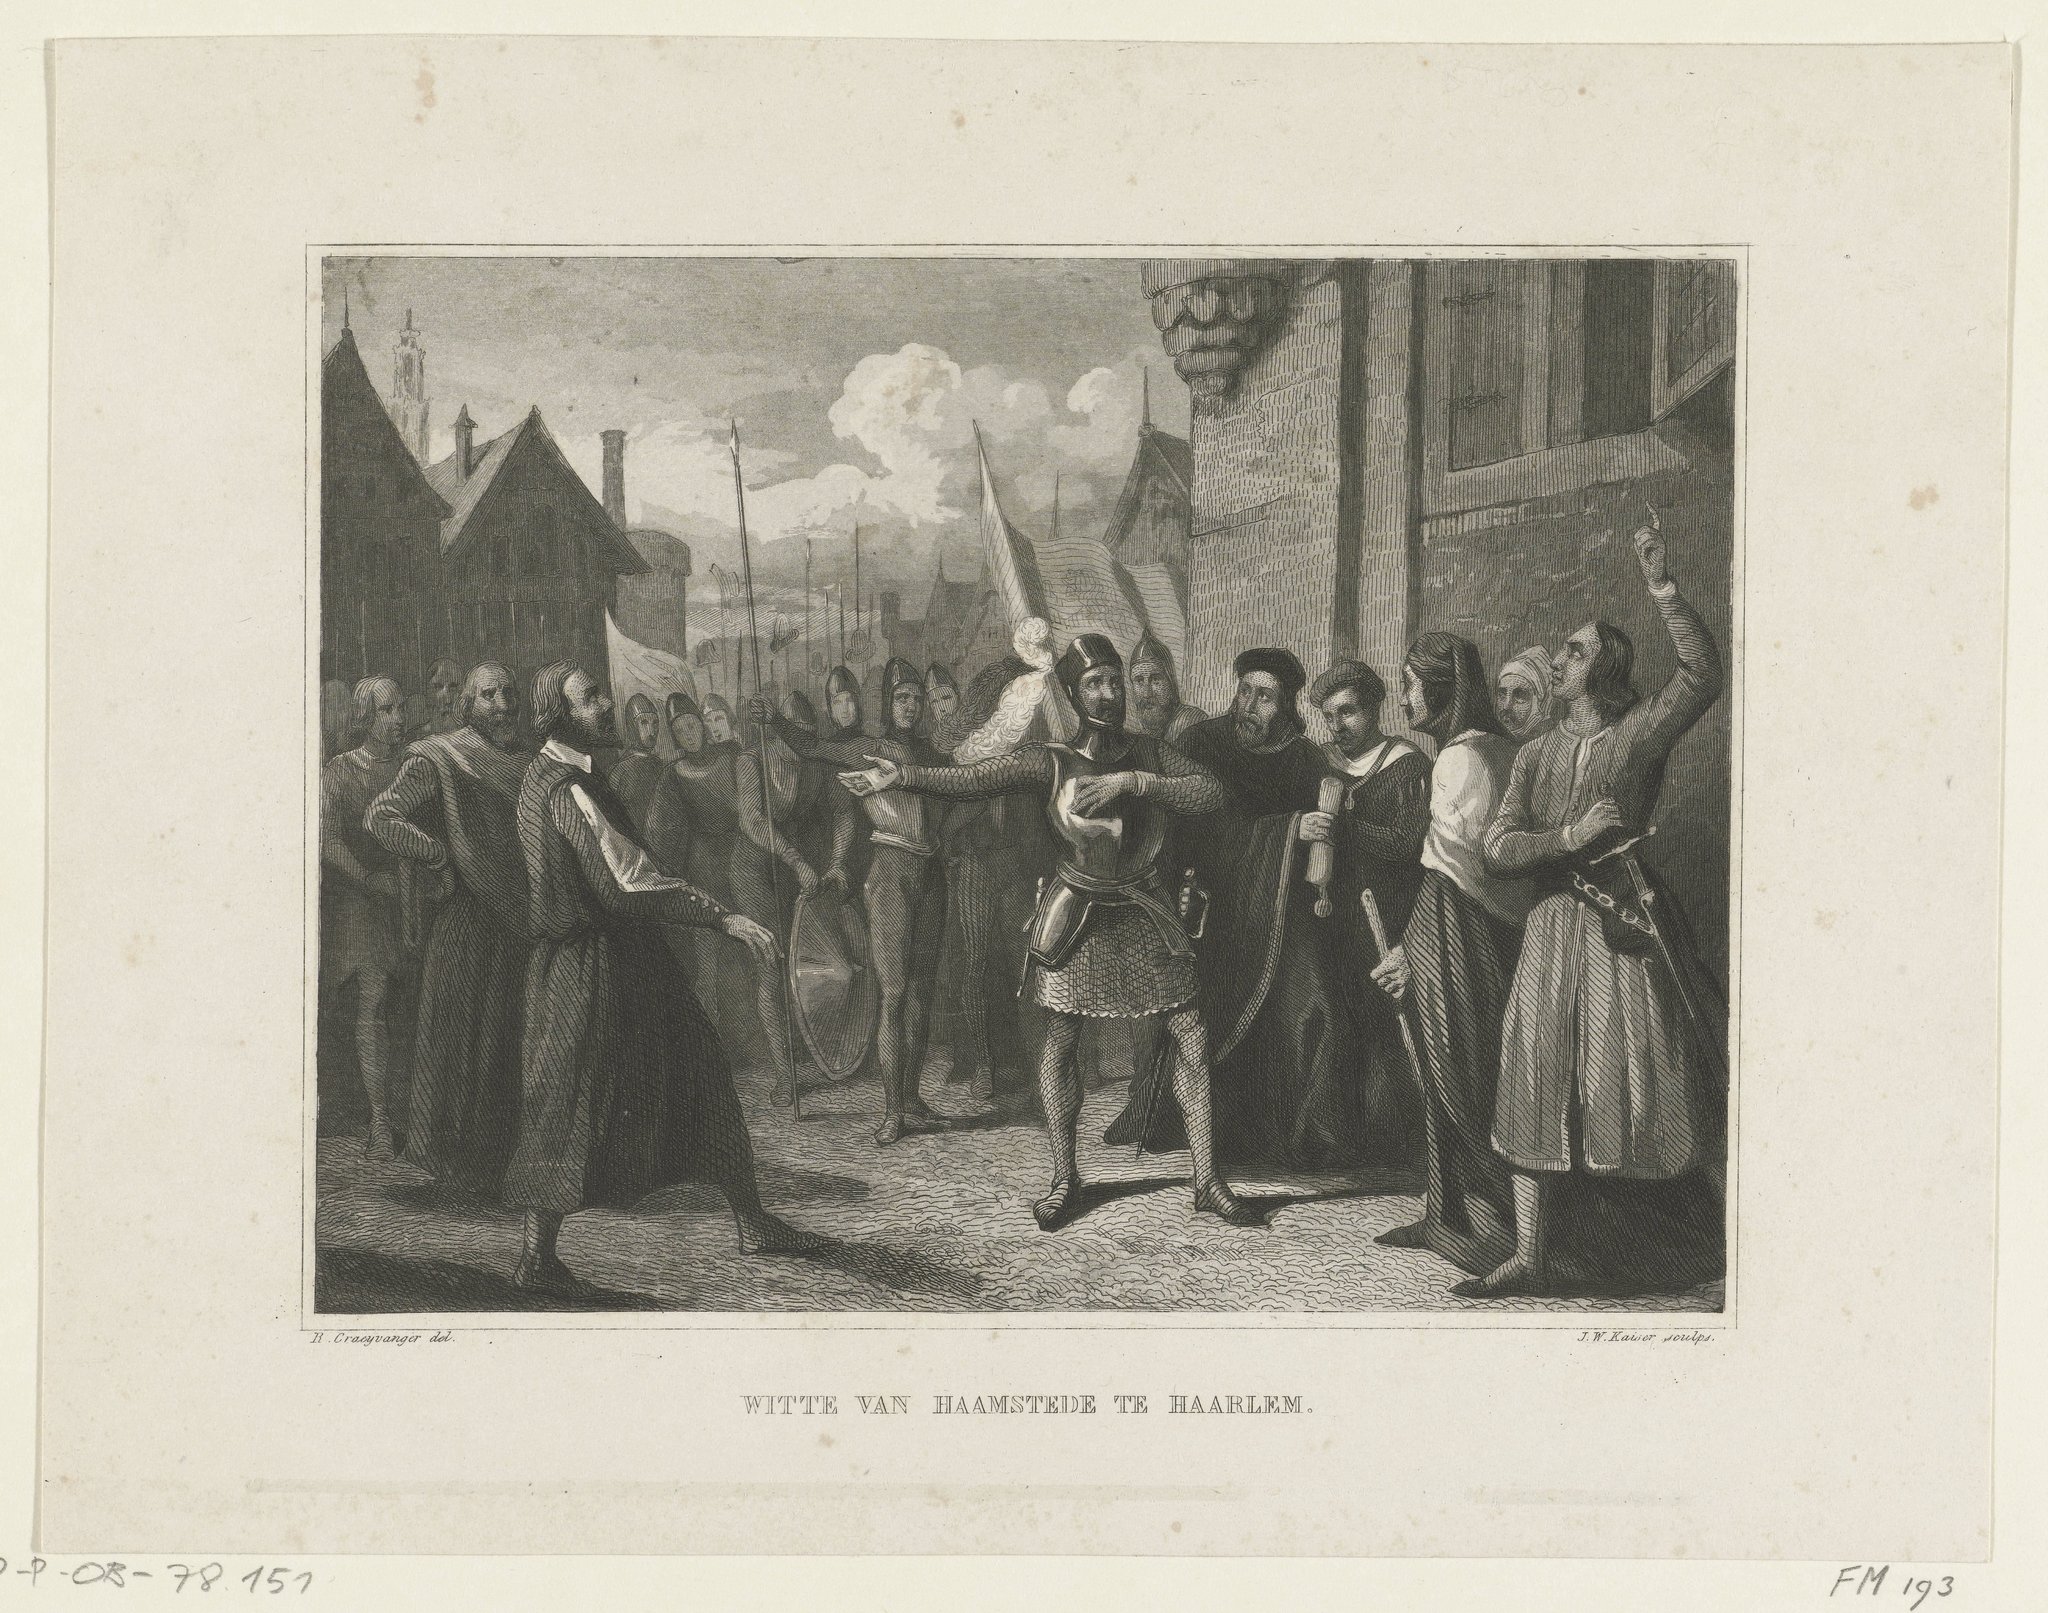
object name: history print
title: Witte van Haemstede te Haarlem, 1304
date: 1842-1844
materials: paper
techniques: engraving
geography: netherlands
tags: haarlem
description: De ridder Witte van Haemstede tussen een menigte personen op de markt te Haarlem. Na de overwinning op en de verdrijving van de Vlamingen in 1304.